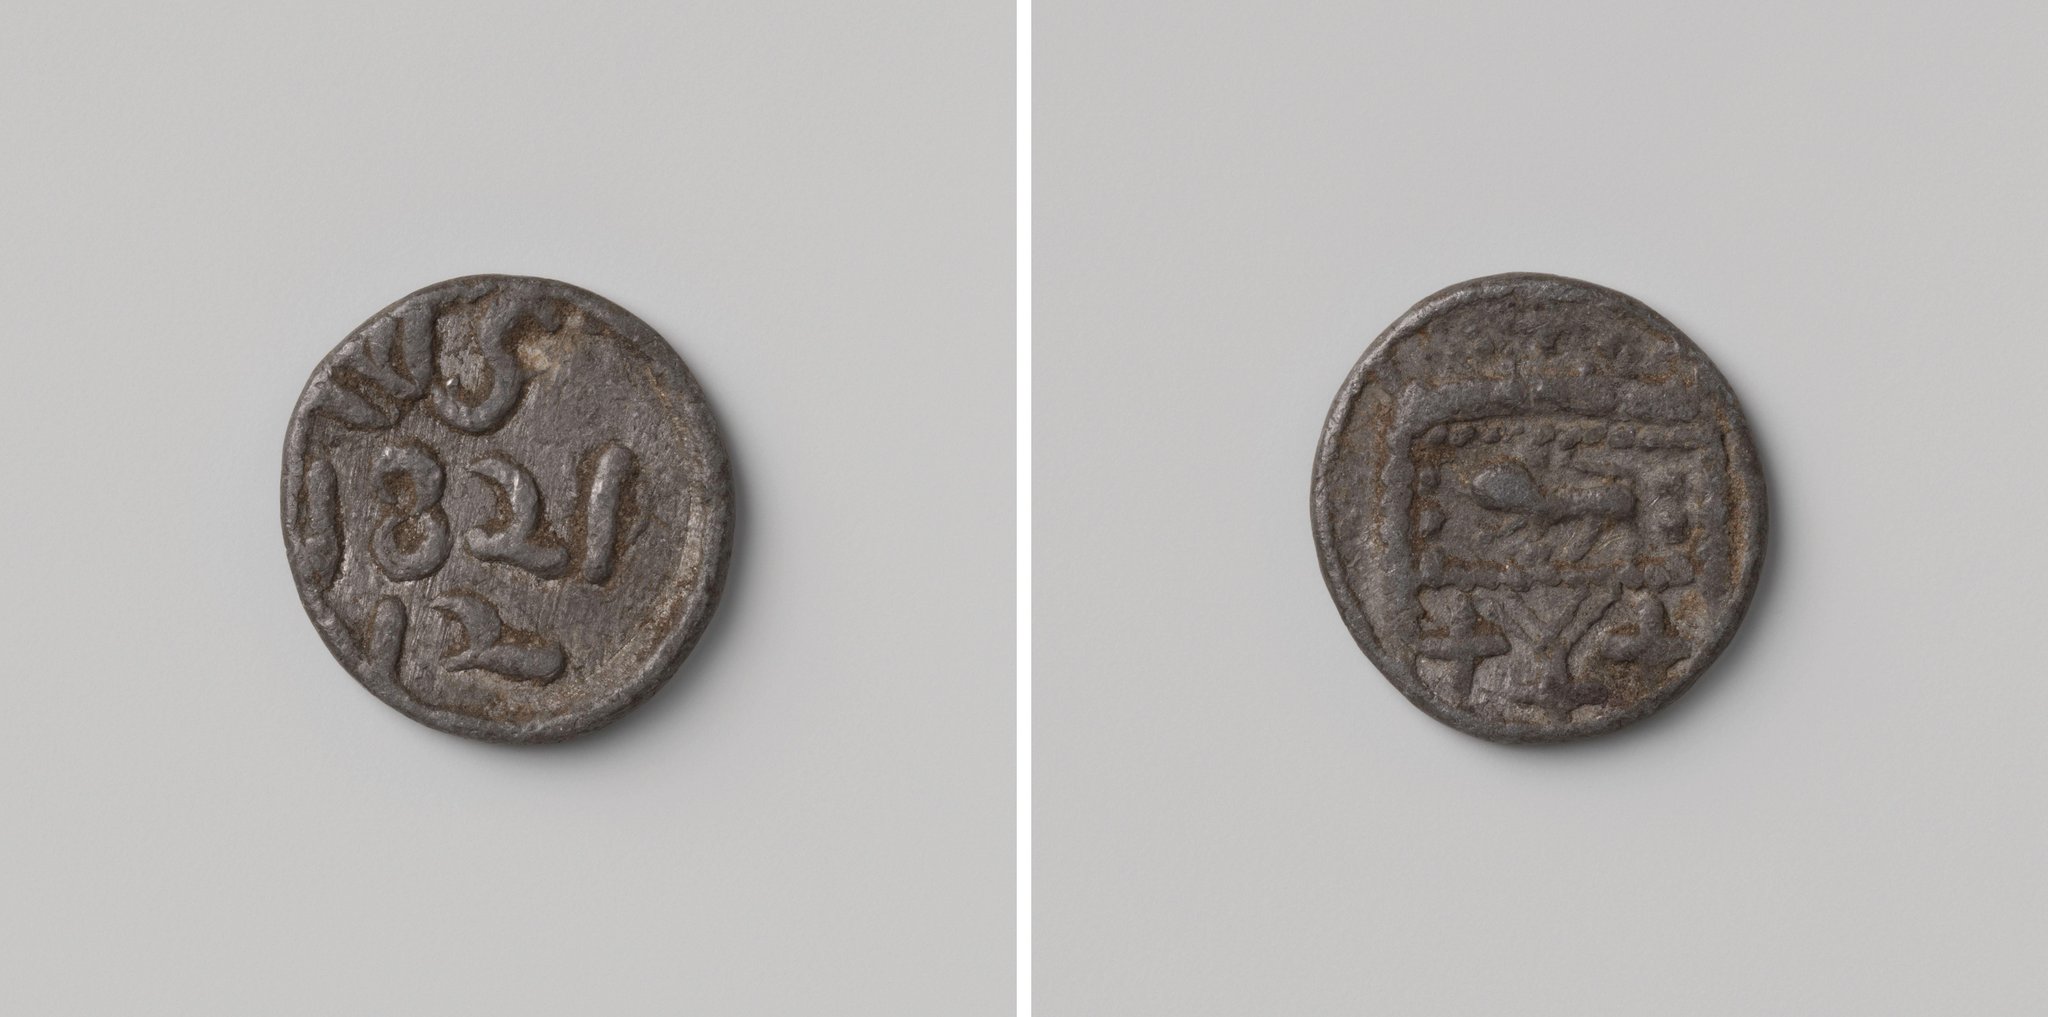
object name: tax token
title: Loden penning voor Willemstad met WS 1821 12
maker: Anonymous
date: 1821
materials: lead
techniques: striking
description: Voorzijde: opschrift WS 1821 12. Keerzijde: leeuw in compartiment; onder en boven kruisen